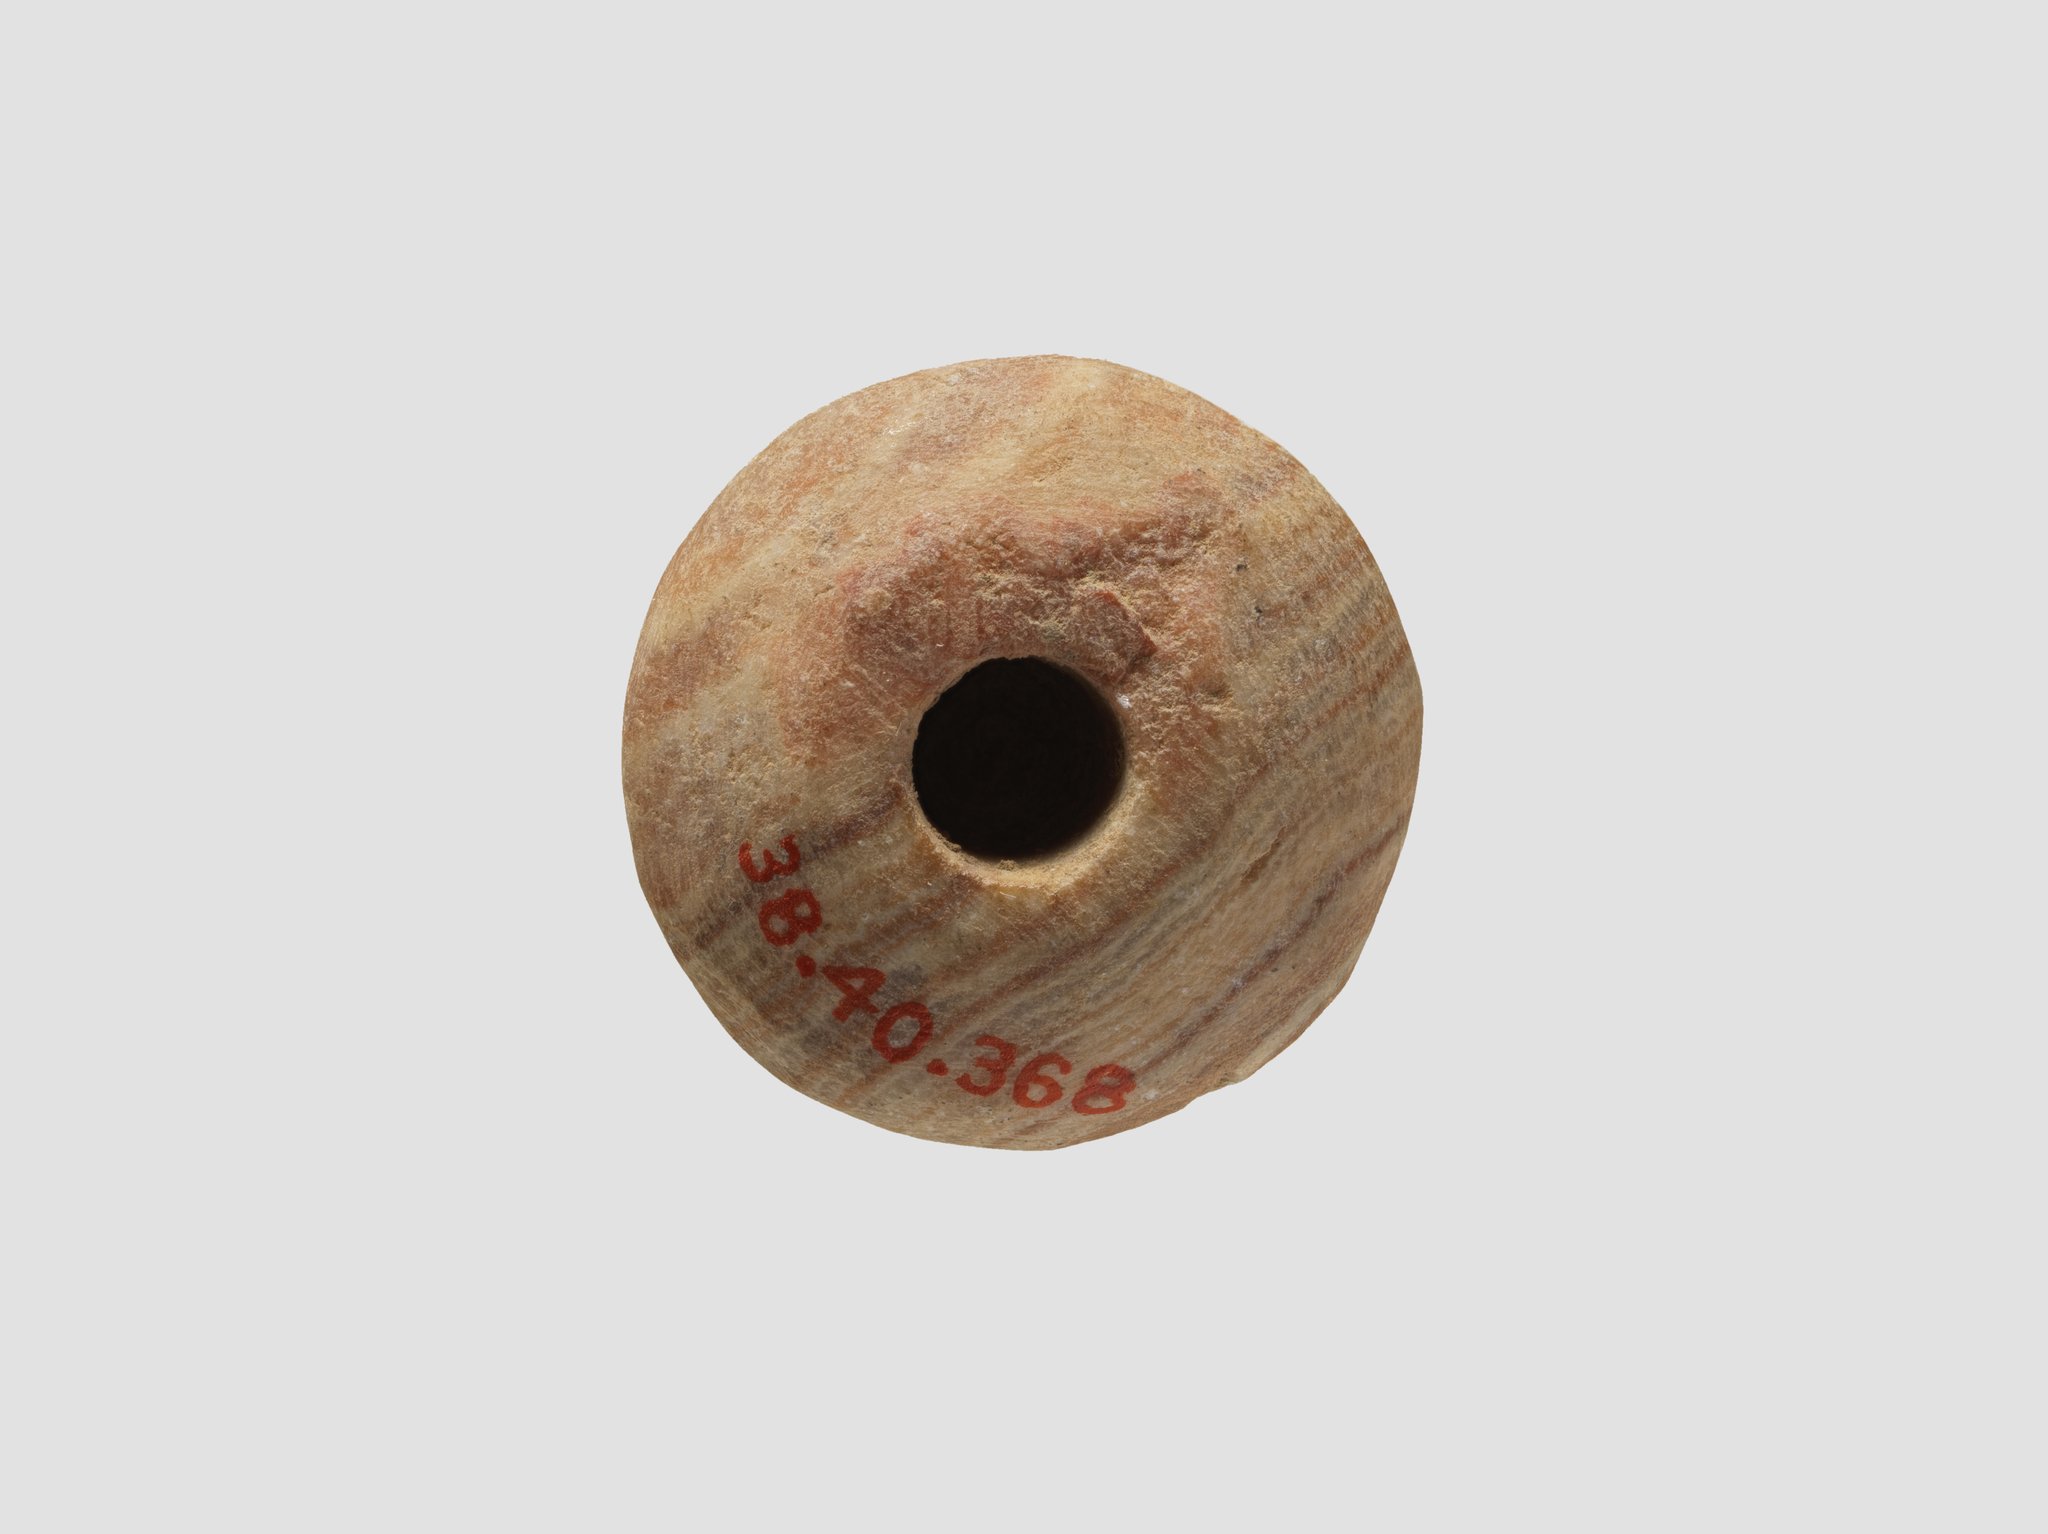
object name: whorl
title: Spindle whorl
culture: iranian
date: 5000-2001 BCE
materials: stone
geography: iran